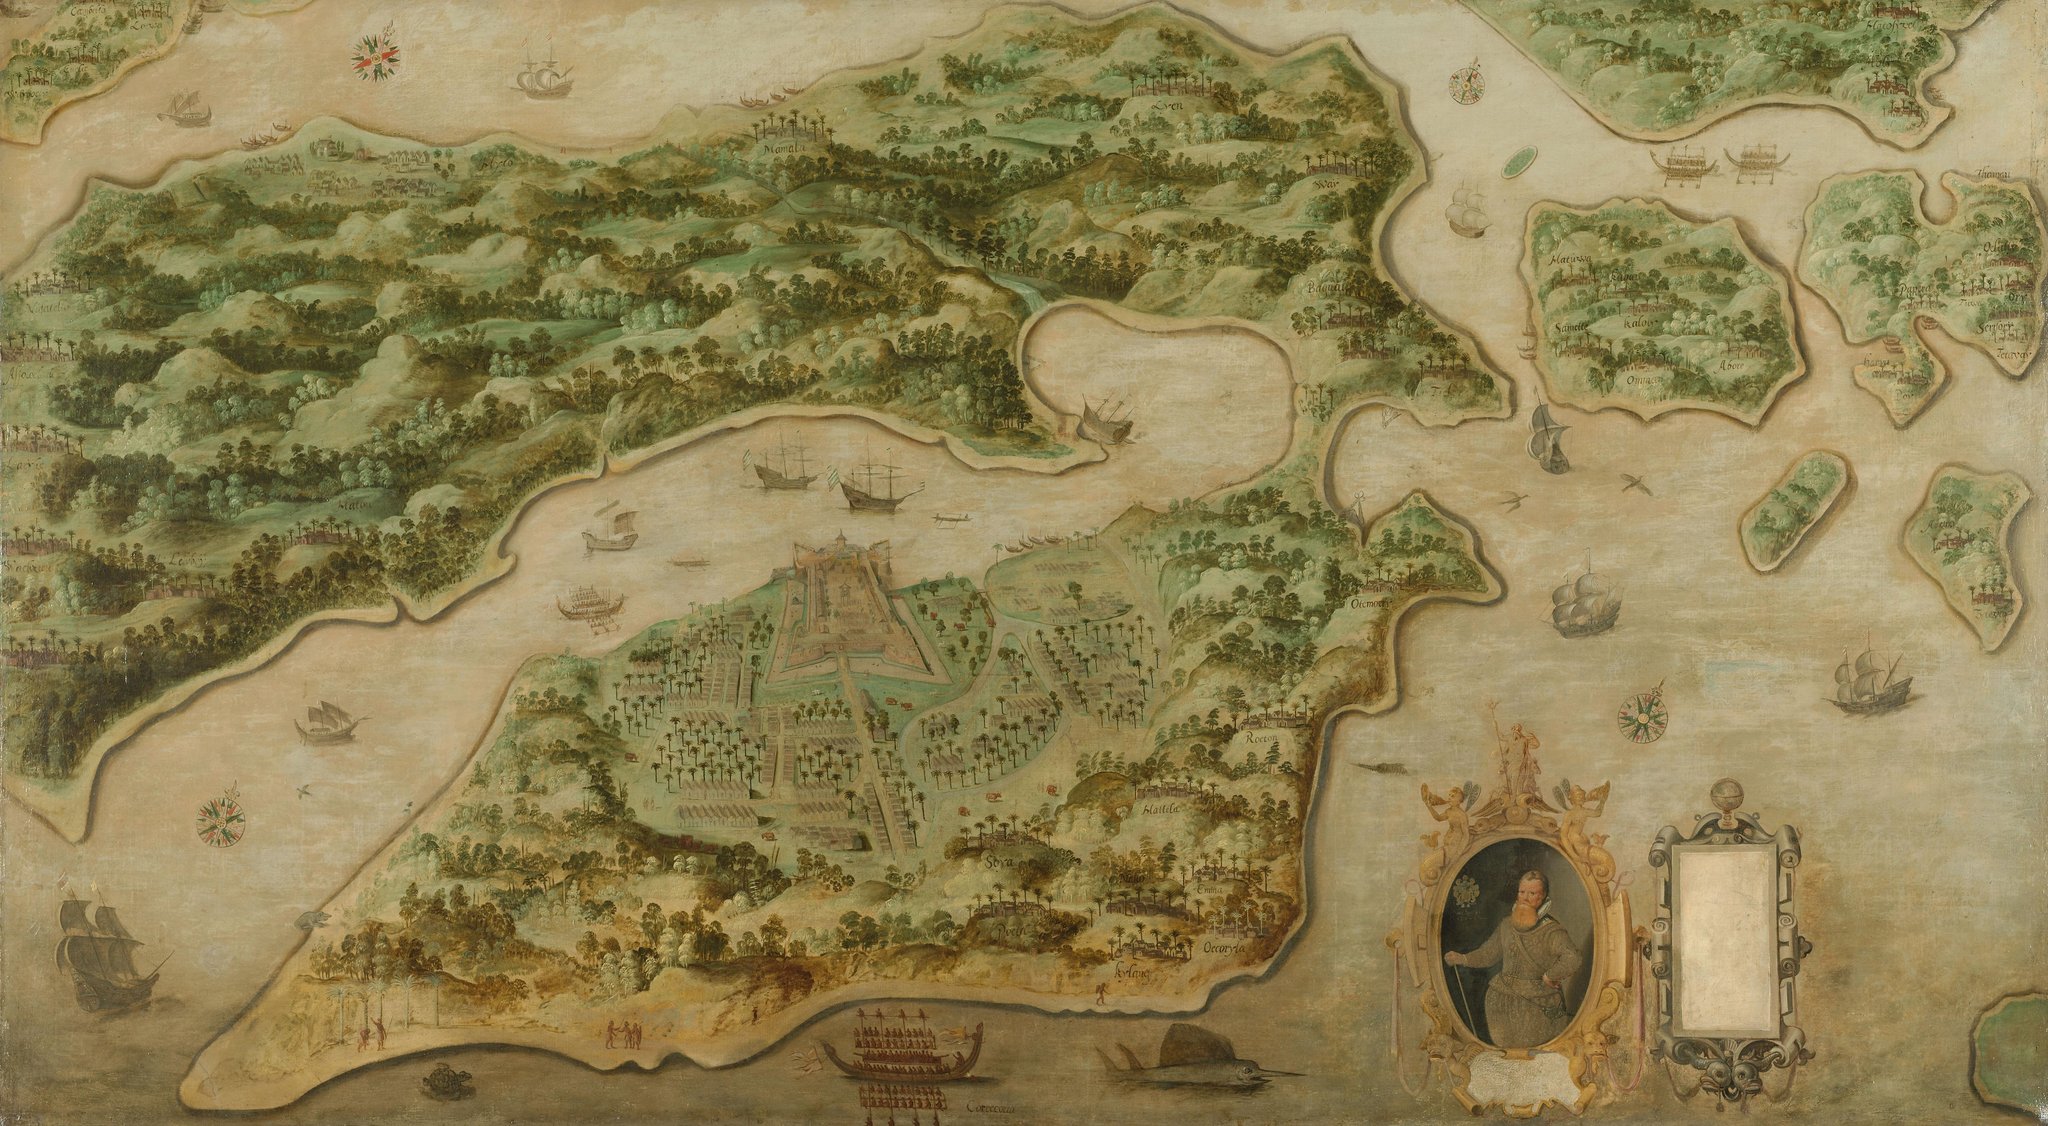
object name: painting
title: View of Ambon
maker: Anonymous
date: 1617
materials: canvas, oil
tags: gouda, official, fortress, bird's eye view ~ representation of building (+ variant), landscapes in the non-temperate zone, exotic landscapes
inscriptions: inscription and date, lower right, in the cartouche: ‘Ætatis Suae 46 / 1617’, inscription, on the islands: ‘Waÿboetÿ / Enela / Cambello / Loewa / Nufatello / Affoloelonu / Larÿke / Wackzieri / Afan / Lelÿboÿ / Matou / Myto / Mamala / Lyen / Waÿ / Baguale / Tiel / Otemerÿ / Roeton / Mattela / Emma / Occoryla / Nako / Kylang / Soya / Poeta / Correcorra / Matofyvel / Moly / Latu / Matuwa / Kabau / Samette / Kaloly / Omman / Abore / Jhamau / Oelattÿ / Orÿ / Seriforÿ / Tetavaÿ / Tuwa / Pavera / harya / Boÿ / Ametto / Tytevay’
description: This is a view of the Mollucan island of Ambon with a portrait of its first Dutch governor, Frederik Houtman, at the lower right. At centre is the Portuguese Fort Victoria, which was seized by the Dutch East India Company in 1605 because of the lucrative clove production. Houtman initially maintained good contacts with the Ambonese chiefs, but the company later mounted ruthless ‘punitive expeditions’ to counter the sale of cloves to its rivals.